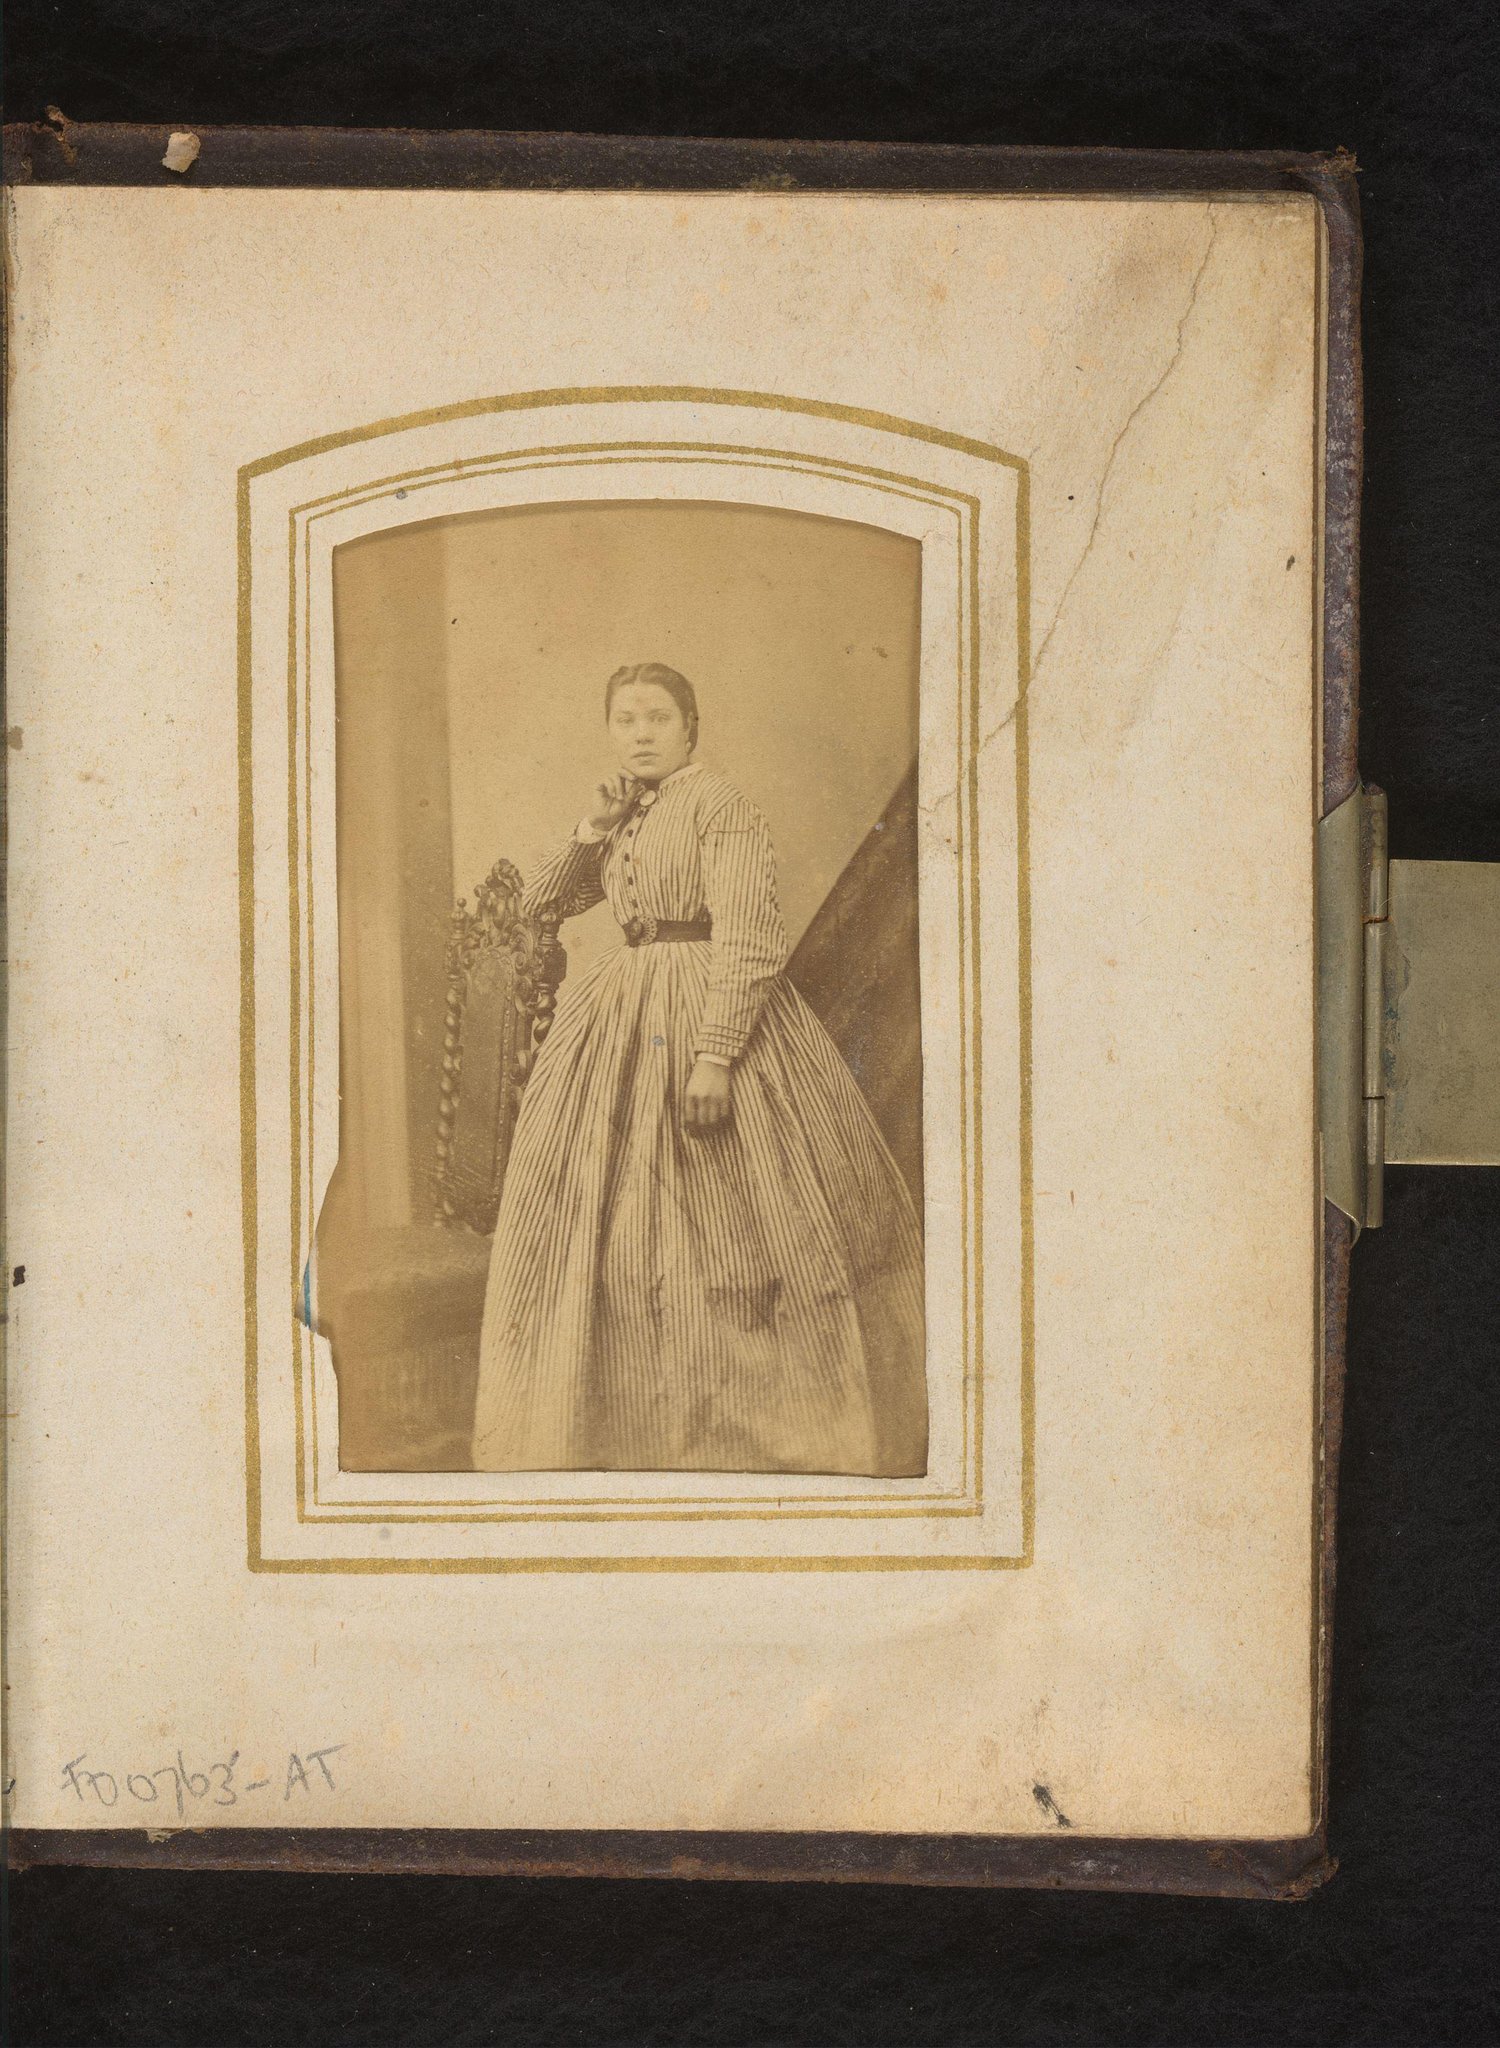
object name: album leaf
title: Portret van een vrouw, staand bij een stoel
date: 1870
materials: cardboard, photographic support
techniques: albumen print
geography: amsterdam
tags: historical persons - bb - woman, standing figure - aa - female human figure, chair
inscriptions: inscription: ‘Photographisch Atelier/ van/ H. C. DONK & Co/ Spiegelstraat/ tusschen de Keizergr. en Kerkstr./ CC 686./ AMSTERDAM.’, annotation: ‘dit portret is/ getrokken den/ 9 Jan 1870,/ en is gegeven aan/ Bertha Blom/ ter gedachtenis/ van C c 16/ Vermaak/ [...]’